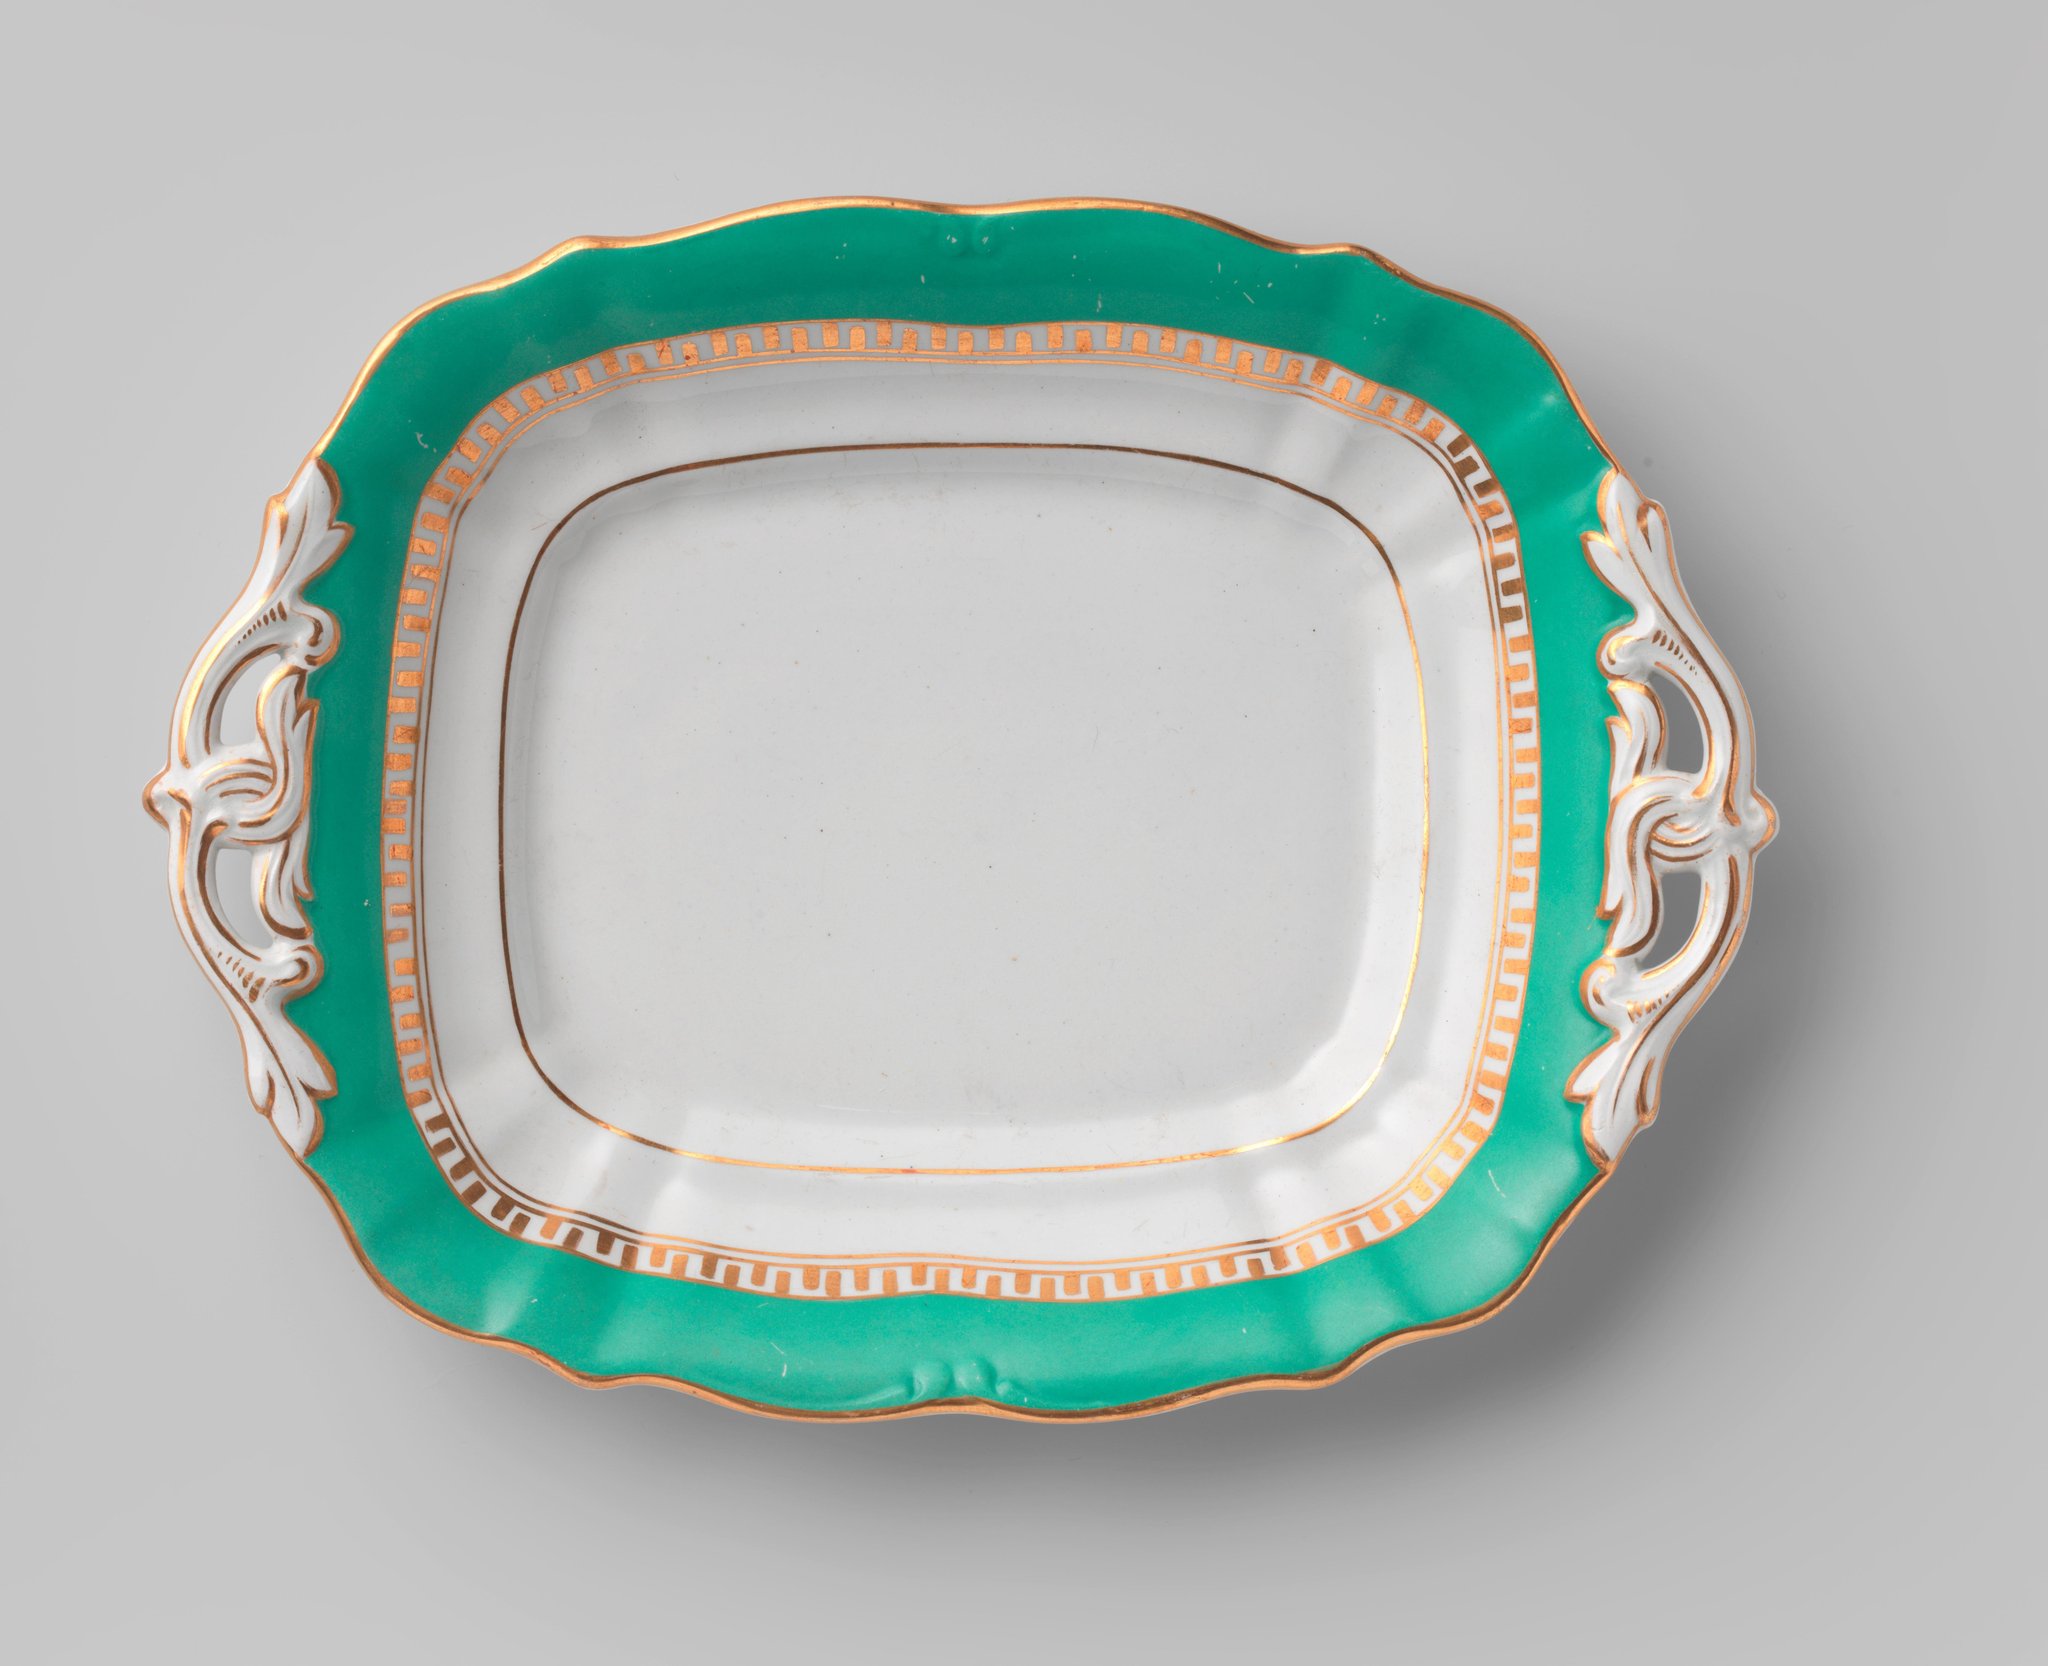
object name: dish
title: Schaal, langwerpig, met groene rand en gouden Griekse band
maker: petrus regout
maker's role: plateelbakker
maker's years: 1801-1879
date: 1865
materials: earthenware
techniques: transfer decoration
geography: maastricht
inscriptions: mark: ‘P. REGOUT HOLLAND MAASTRICHT’, check stamp: ‘P. REGOUT // MAASTRICHT // 2X 15’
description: Schaal van aardewerk, langwerpig, geschulpt, met groene rand en gouden Griekse band.